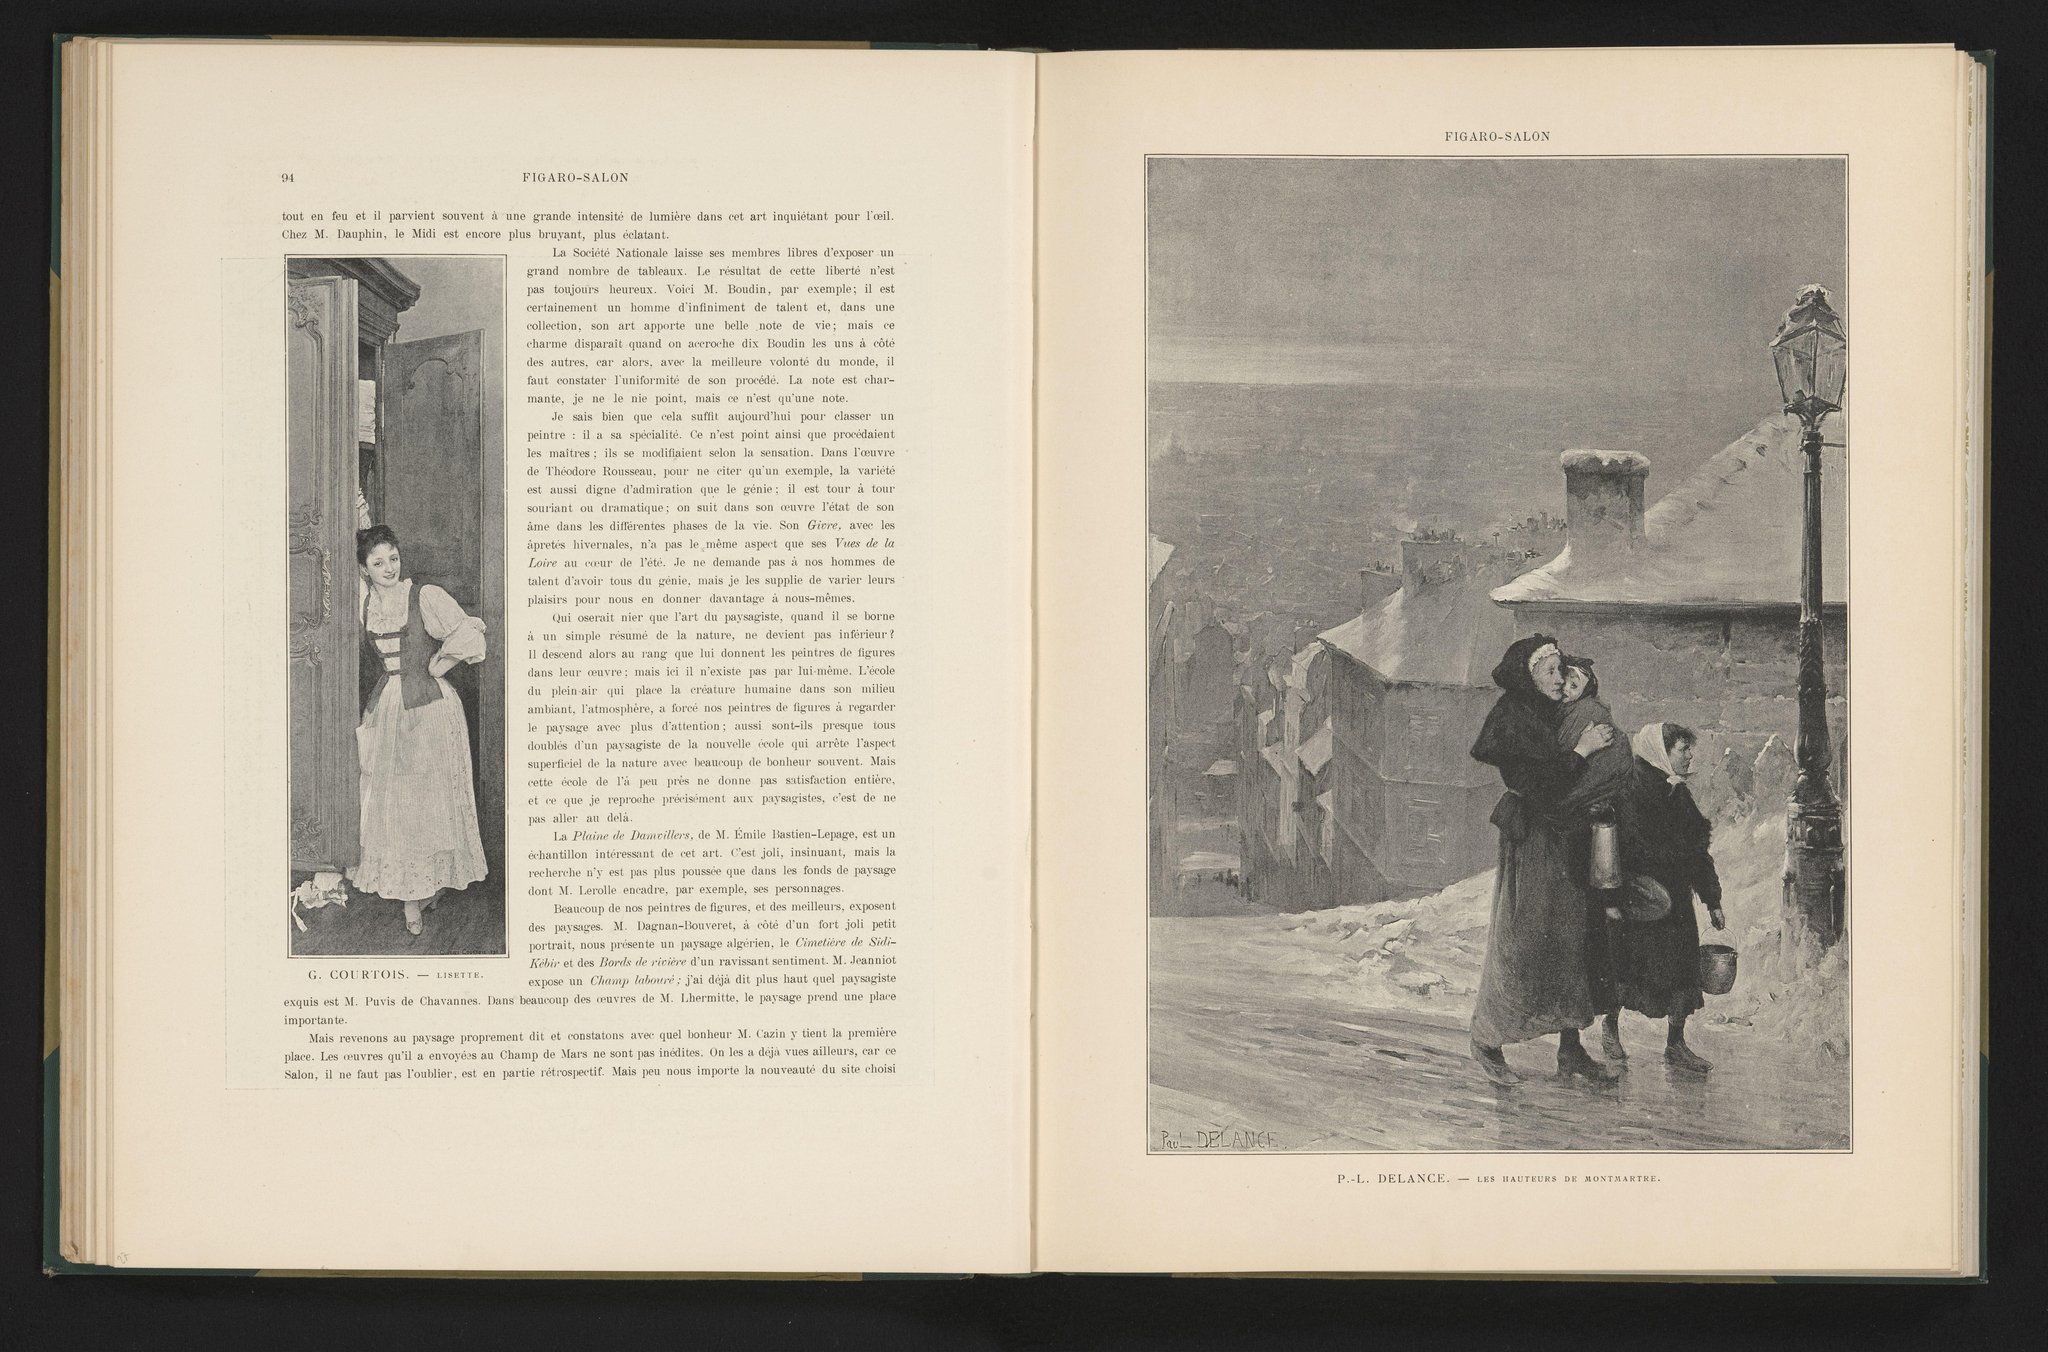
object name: reproduction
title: Reproductie van een schilderij van een straatgezicht te Parijs in de sneeuw door Paul-Louis Delance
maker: Anonymous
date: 1885-1901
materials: paper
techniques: autotype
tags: snow, street (+ city(-scape) with figures, staffage), paris